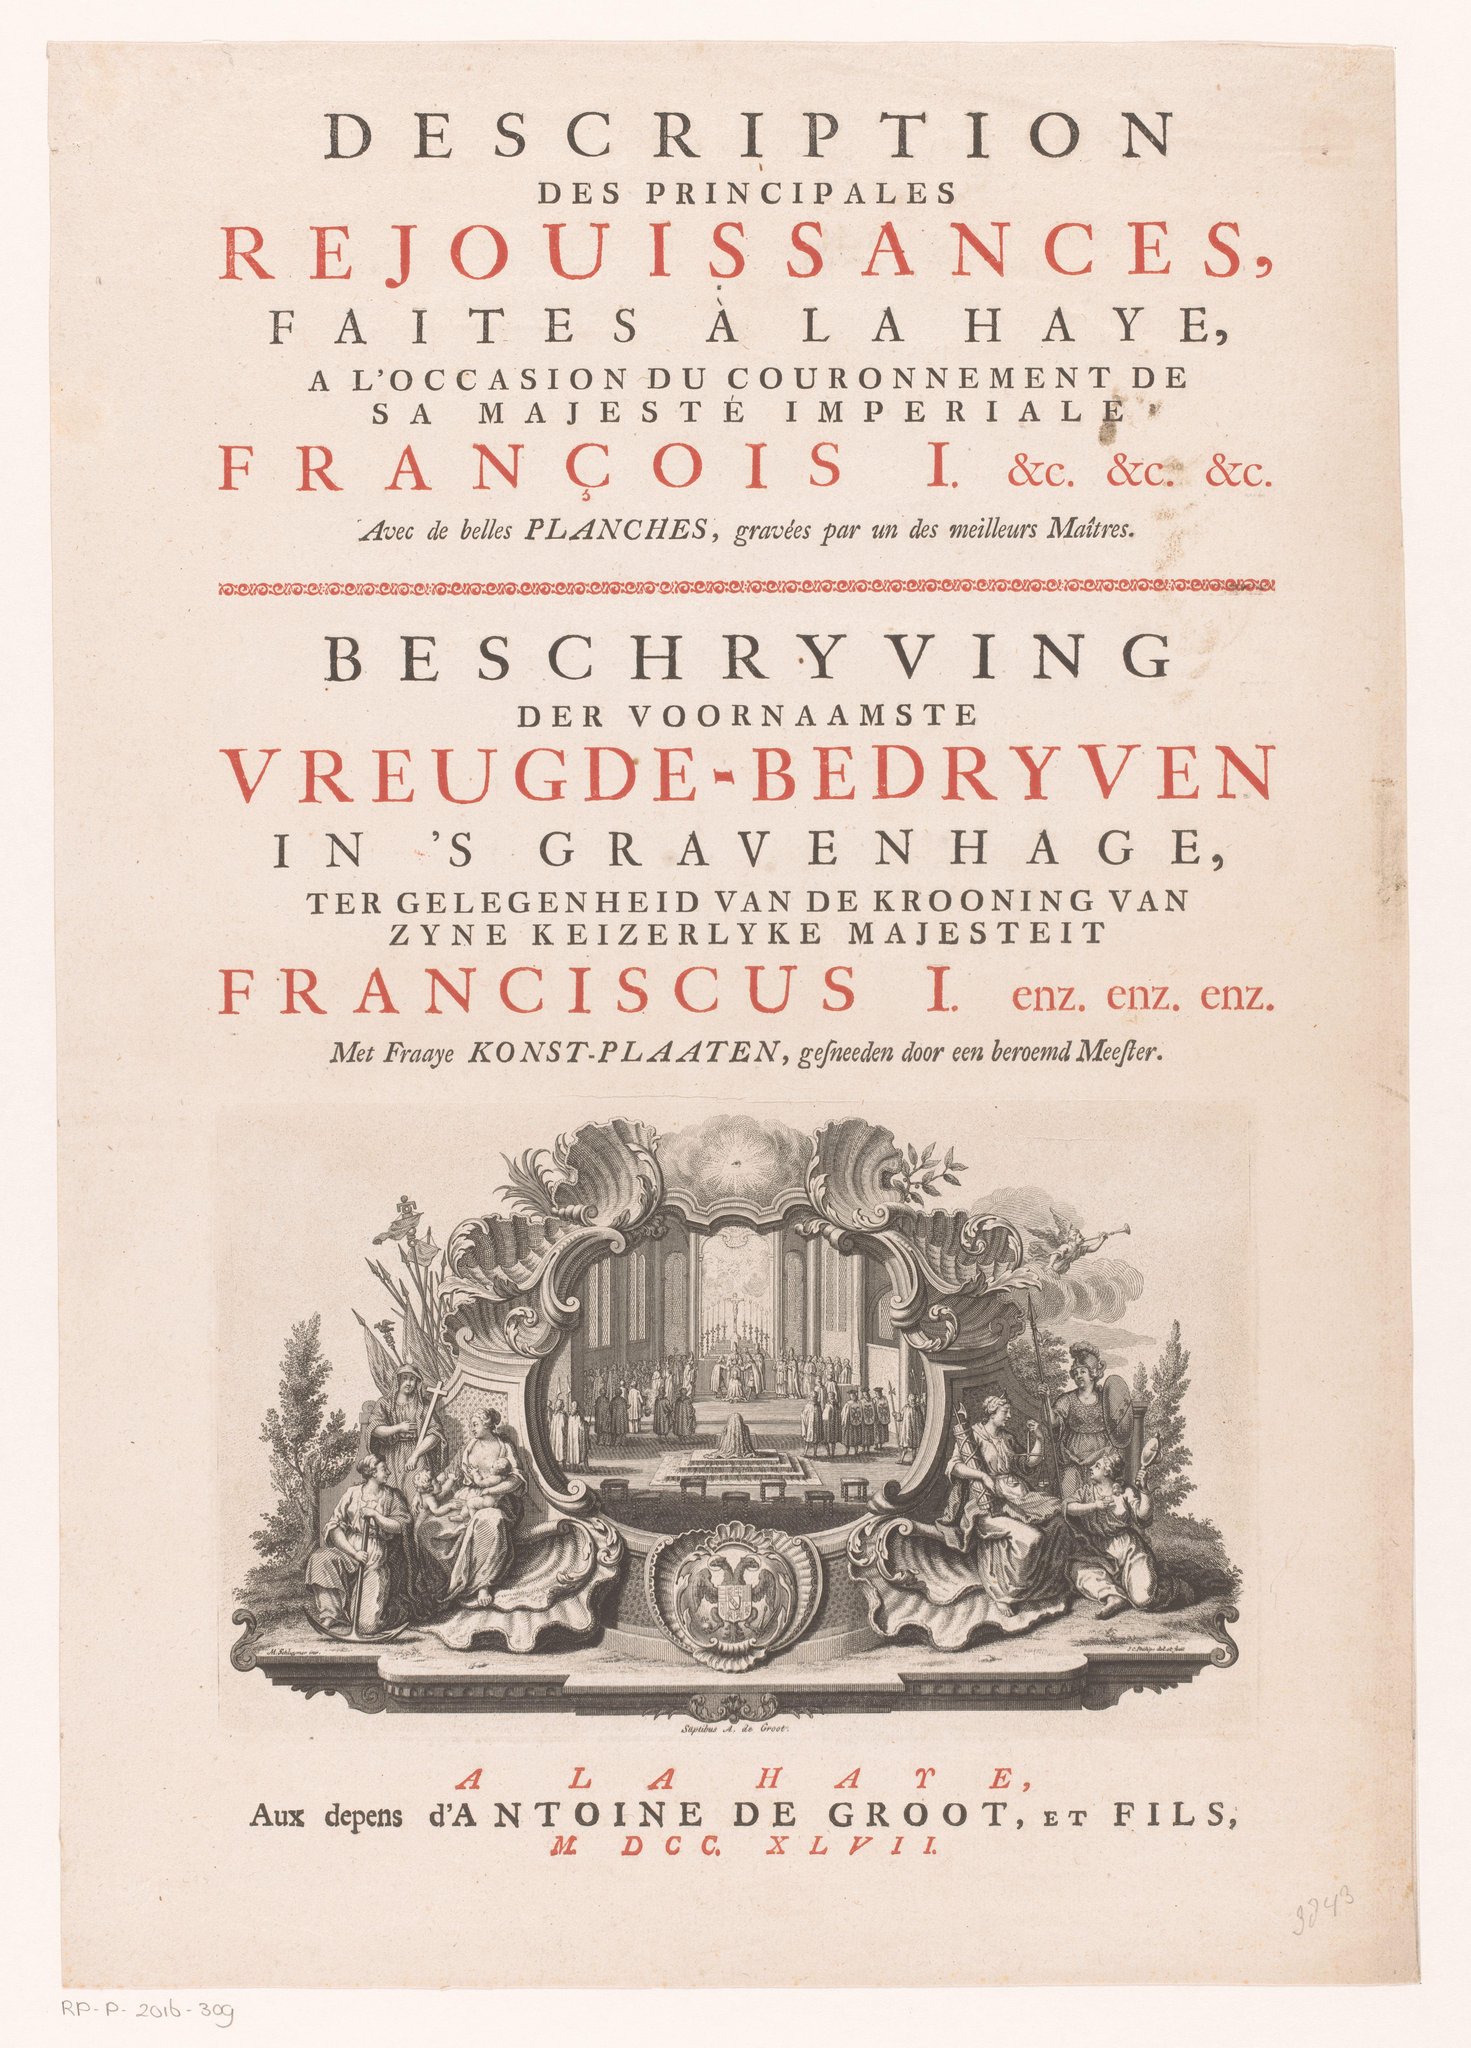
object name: print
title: Titelprent van een plaatwerk over de kroning van Frans I Stefan tot keizer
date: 1747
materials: paper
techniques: engraving, etching, letterpress printing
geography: the hague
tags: frans i stefan (duits keizer), 'sapientia' and the seven virtues, i.e. the three theological and the four cardinal virtues, during the coronation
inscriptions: date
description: Titelprent van een plaatwerk over de kroning van Frans I Stefan tot keizer op 4-6 oktober 1745. Blad met de titels in het Frans en Nederlands en een groot vignet met de kroning in een kerk. In het randwerk de allegorische figuren van Geloof, Hoop en Liefde en Wijsheid, Rechtvaardigheid en Voorzichtigheid, het keizerlijke wapen en rocailles.